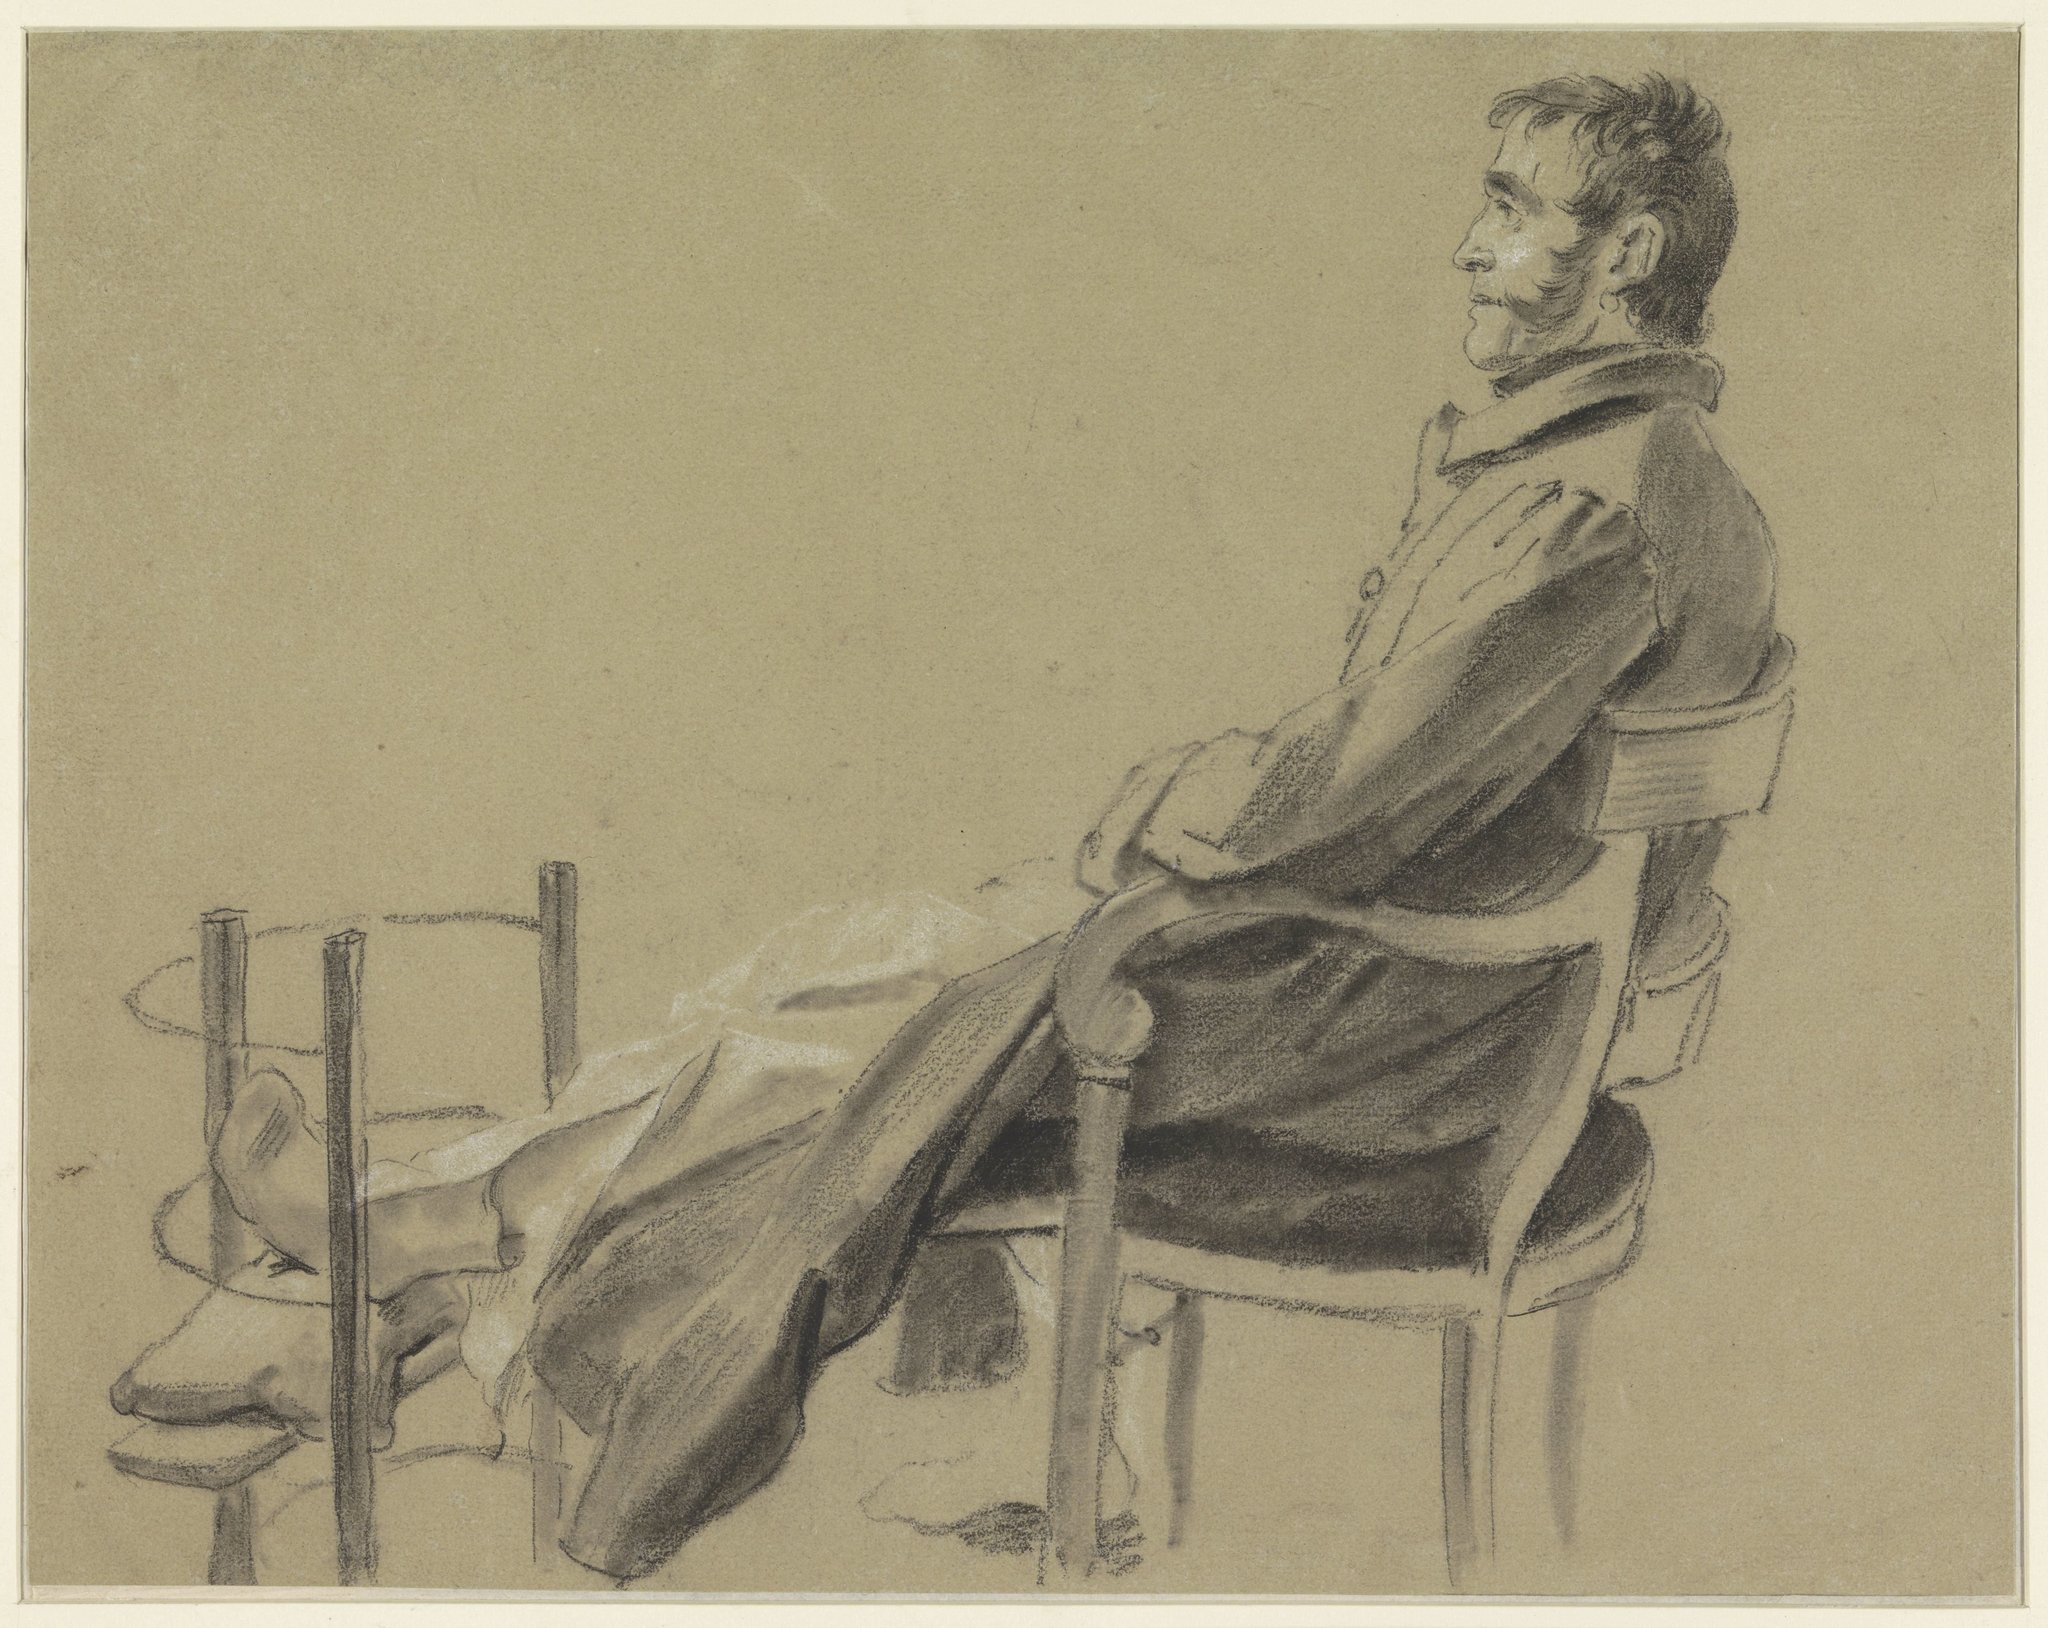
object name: drawing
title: Gewonde soldaat, zittend in een stoel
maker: jacob joseph eeckhout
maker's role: draughtsman, print maker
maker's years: 1793-1861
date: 1803-1861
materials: chalk, paper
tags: person with a physical disability, disabled soldier